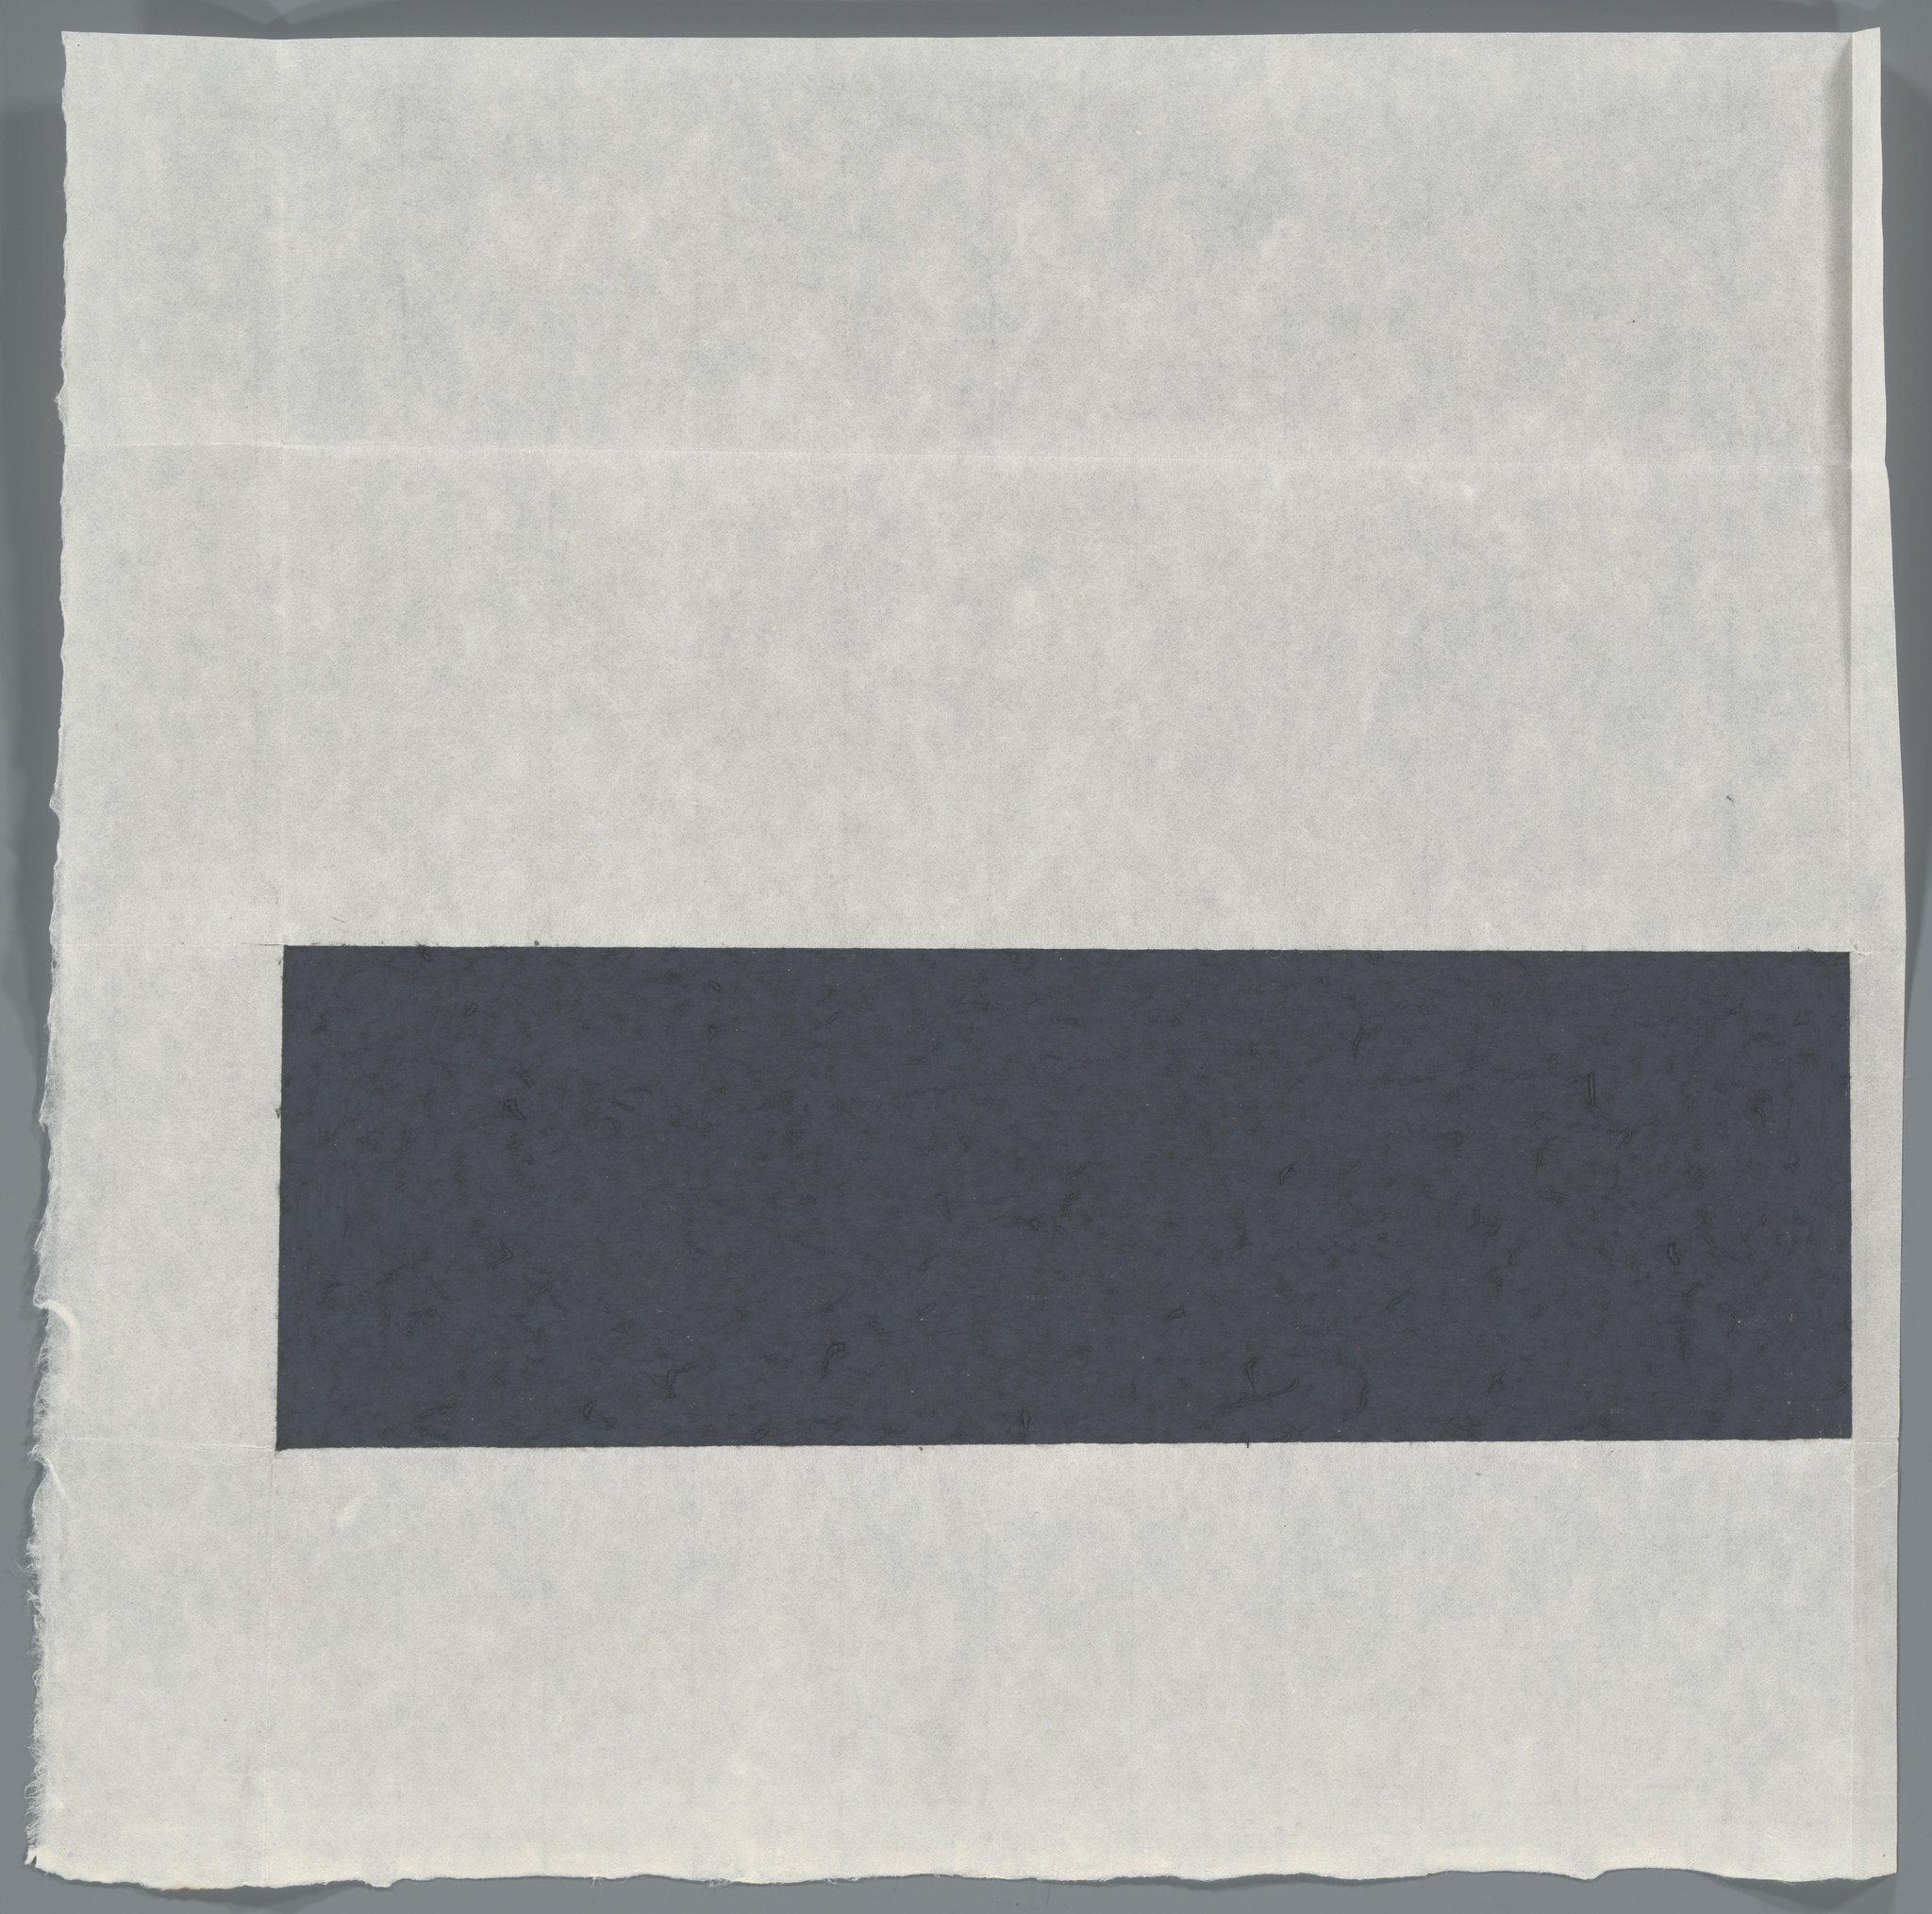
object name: drawing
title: Folded Geometric Shapes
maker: maria van elk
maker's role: artist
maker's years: 1943-2025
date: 1986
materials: paper, pastel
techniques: drawing, folding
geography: netherlands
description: In 1986 Maria van Elk folded eight sheets of thin paper into different shapes, each with its own colour. As a result, colour and shape enter into a relationship. It suddenly appears that green makes a more spatial effect than red and a triangle a wider impression than a hexagon. Like Ellsworth Kelly (whose sculptures are now on display in the Rijksmuseum Gardens), Van Elk merges colour and shape.